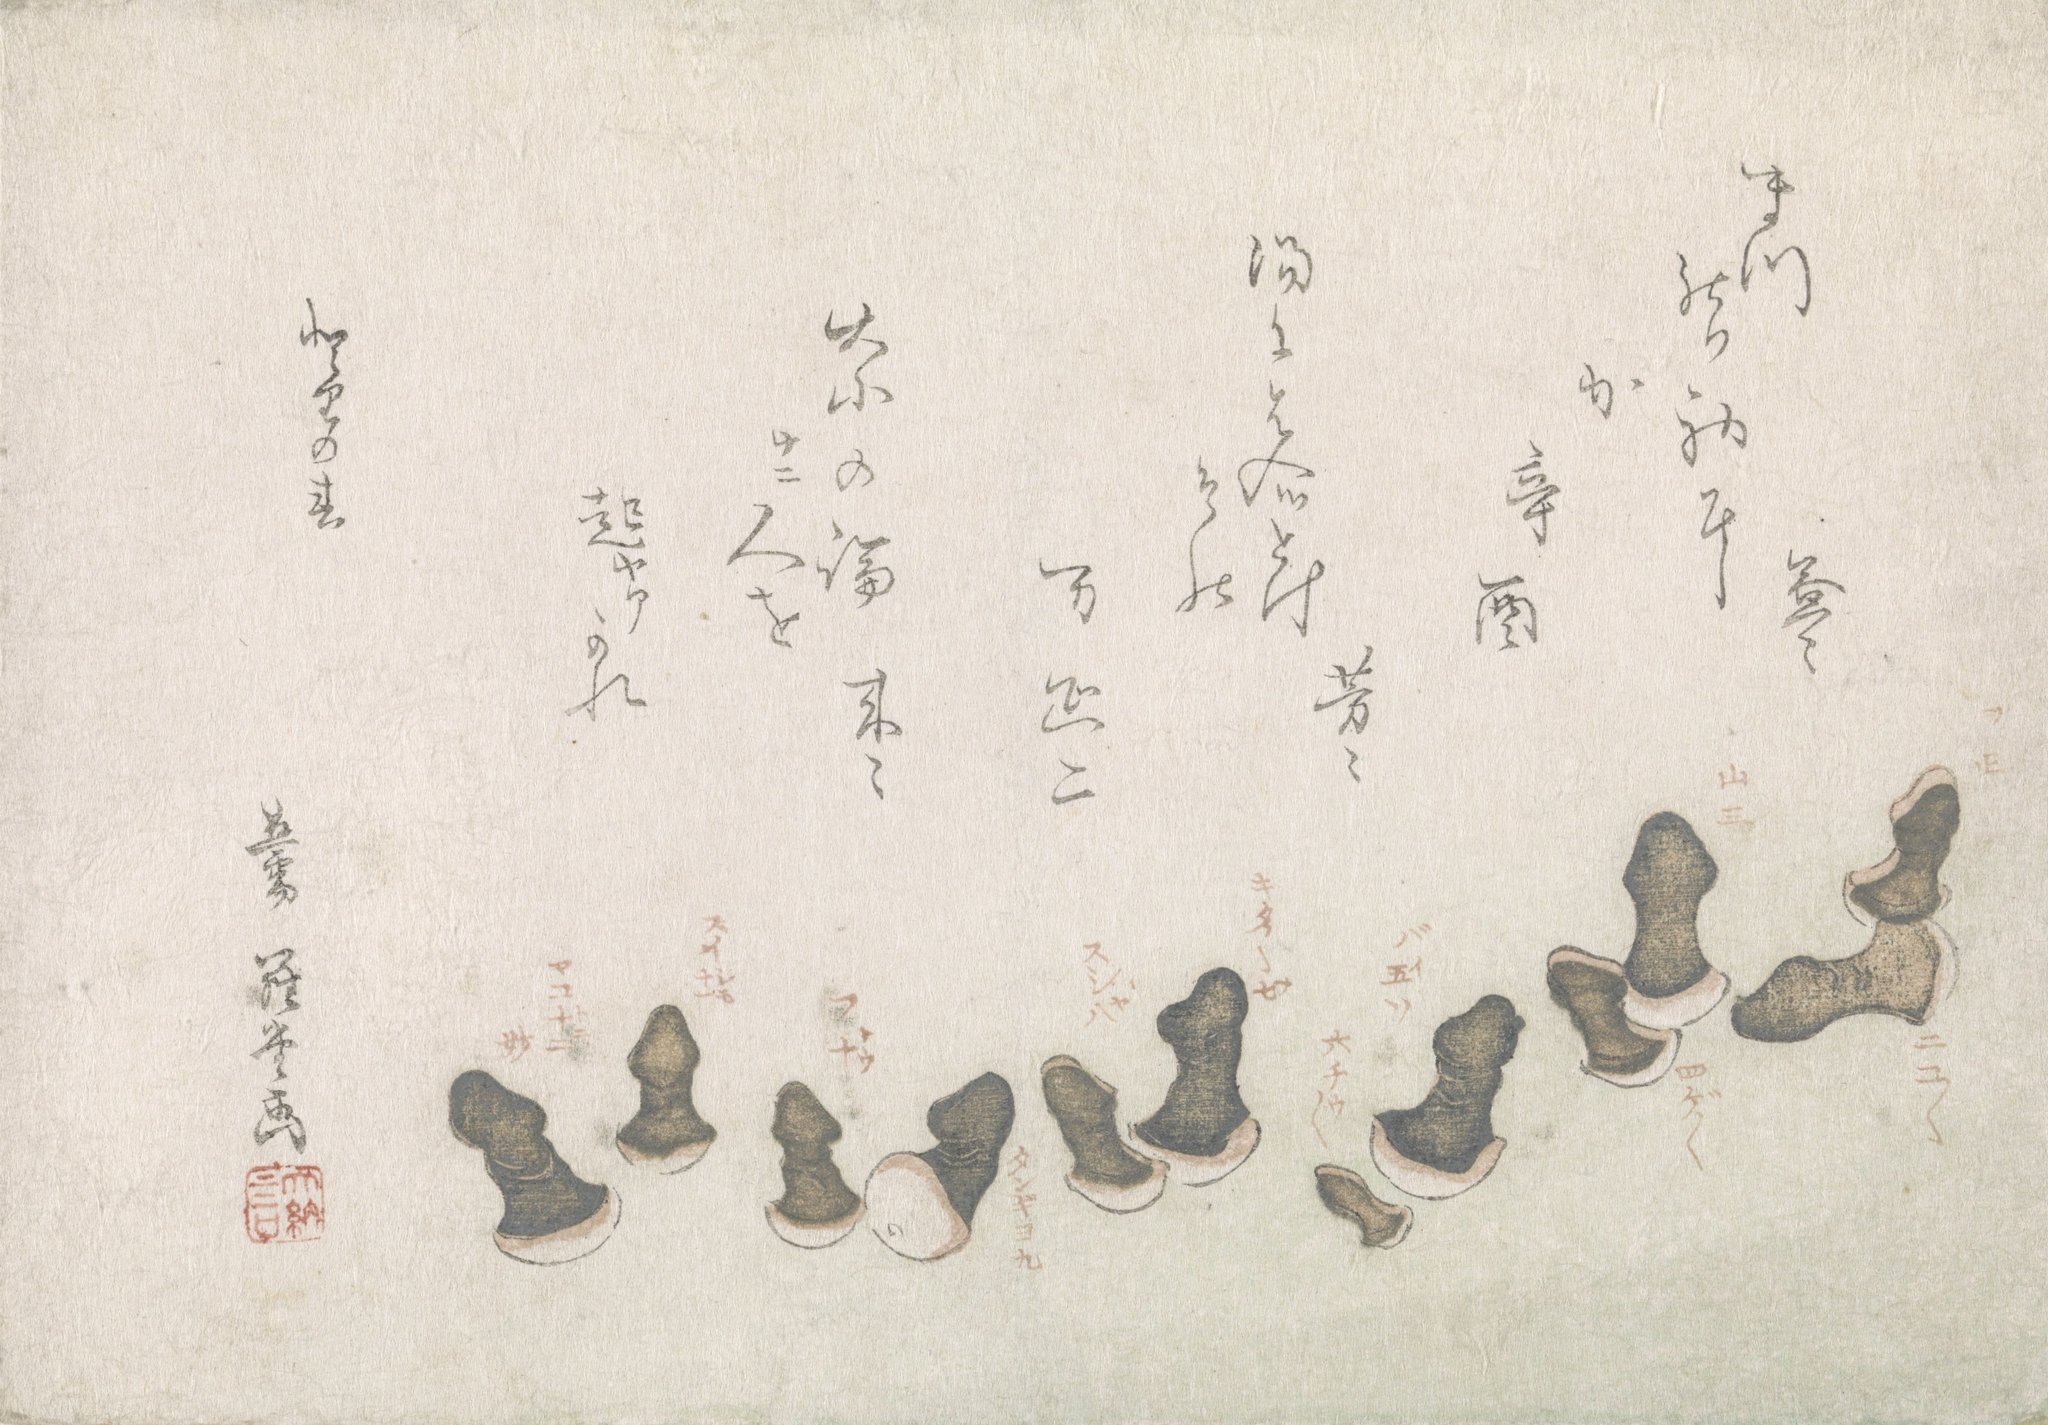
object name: print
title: Egoyomi met paddestoelen als falli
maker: Anonymous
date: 1861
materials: paper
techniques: woodcut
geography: japan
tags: fungi, penis, phallus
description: Een surimono is een luxe uitgevoerde prent waarop beeld met één of meerdere gedichten gecombineerd is. Bij het drukken van een surimono werd vaak gebruik gemaakt van dikker papier, blinddruk en metaal pigmenten, zoals koper- en zilverpoeder. De prenten werden vaak in opdracht van dichters gemaakt en als exclusief geschenk aan vrienden en relaties gegeven. Een egoyomi is een kalender prent, waarop de aanduiding voor de maanden verstopt zit in het ontwerp. Vaak werden egoyomi net als surimono in eigen beheer uitgegeven en aan vrienden kado gedaan. In Japan gebruikte men tot 1873 een maankalender, waarbij de volgorde van de lange en de korte maanden jaarlijks varieerde. Omdat er maar een klein aantal uitgevers kalenders mocht maken, waren particulier uitgeven kalender prenten tegen de regels van de overheid. Om deze regels te omzeilen werden de kalendergegevens verstopt in het prentontwerp.